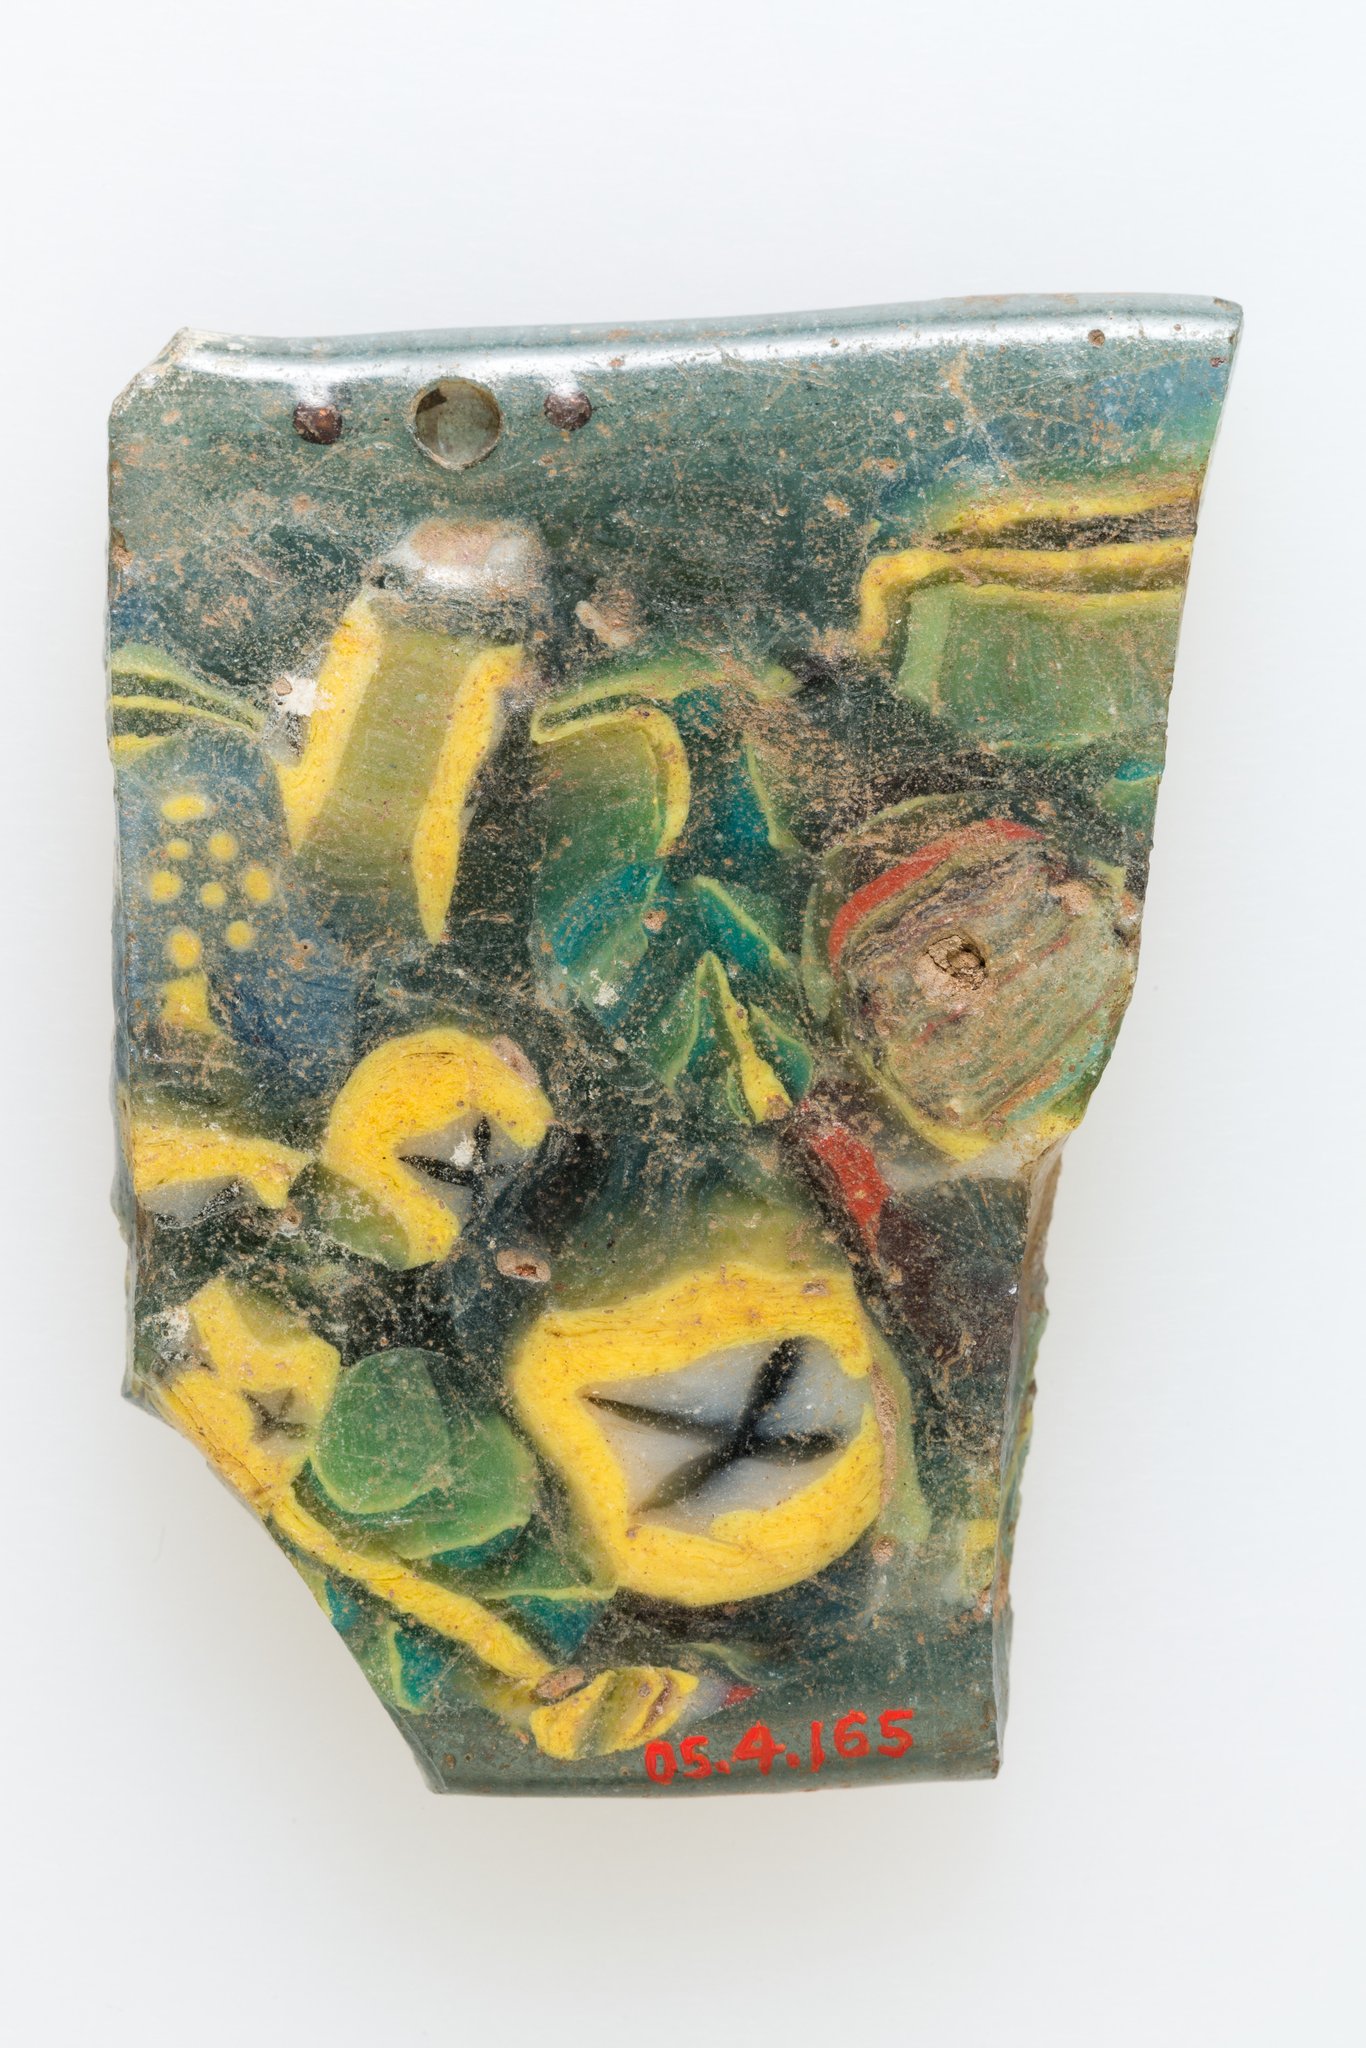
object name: floral plaque, fragment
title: Fragment of floral plaque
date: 100 BCE-100 CE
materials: glass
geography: egypt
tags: flowers